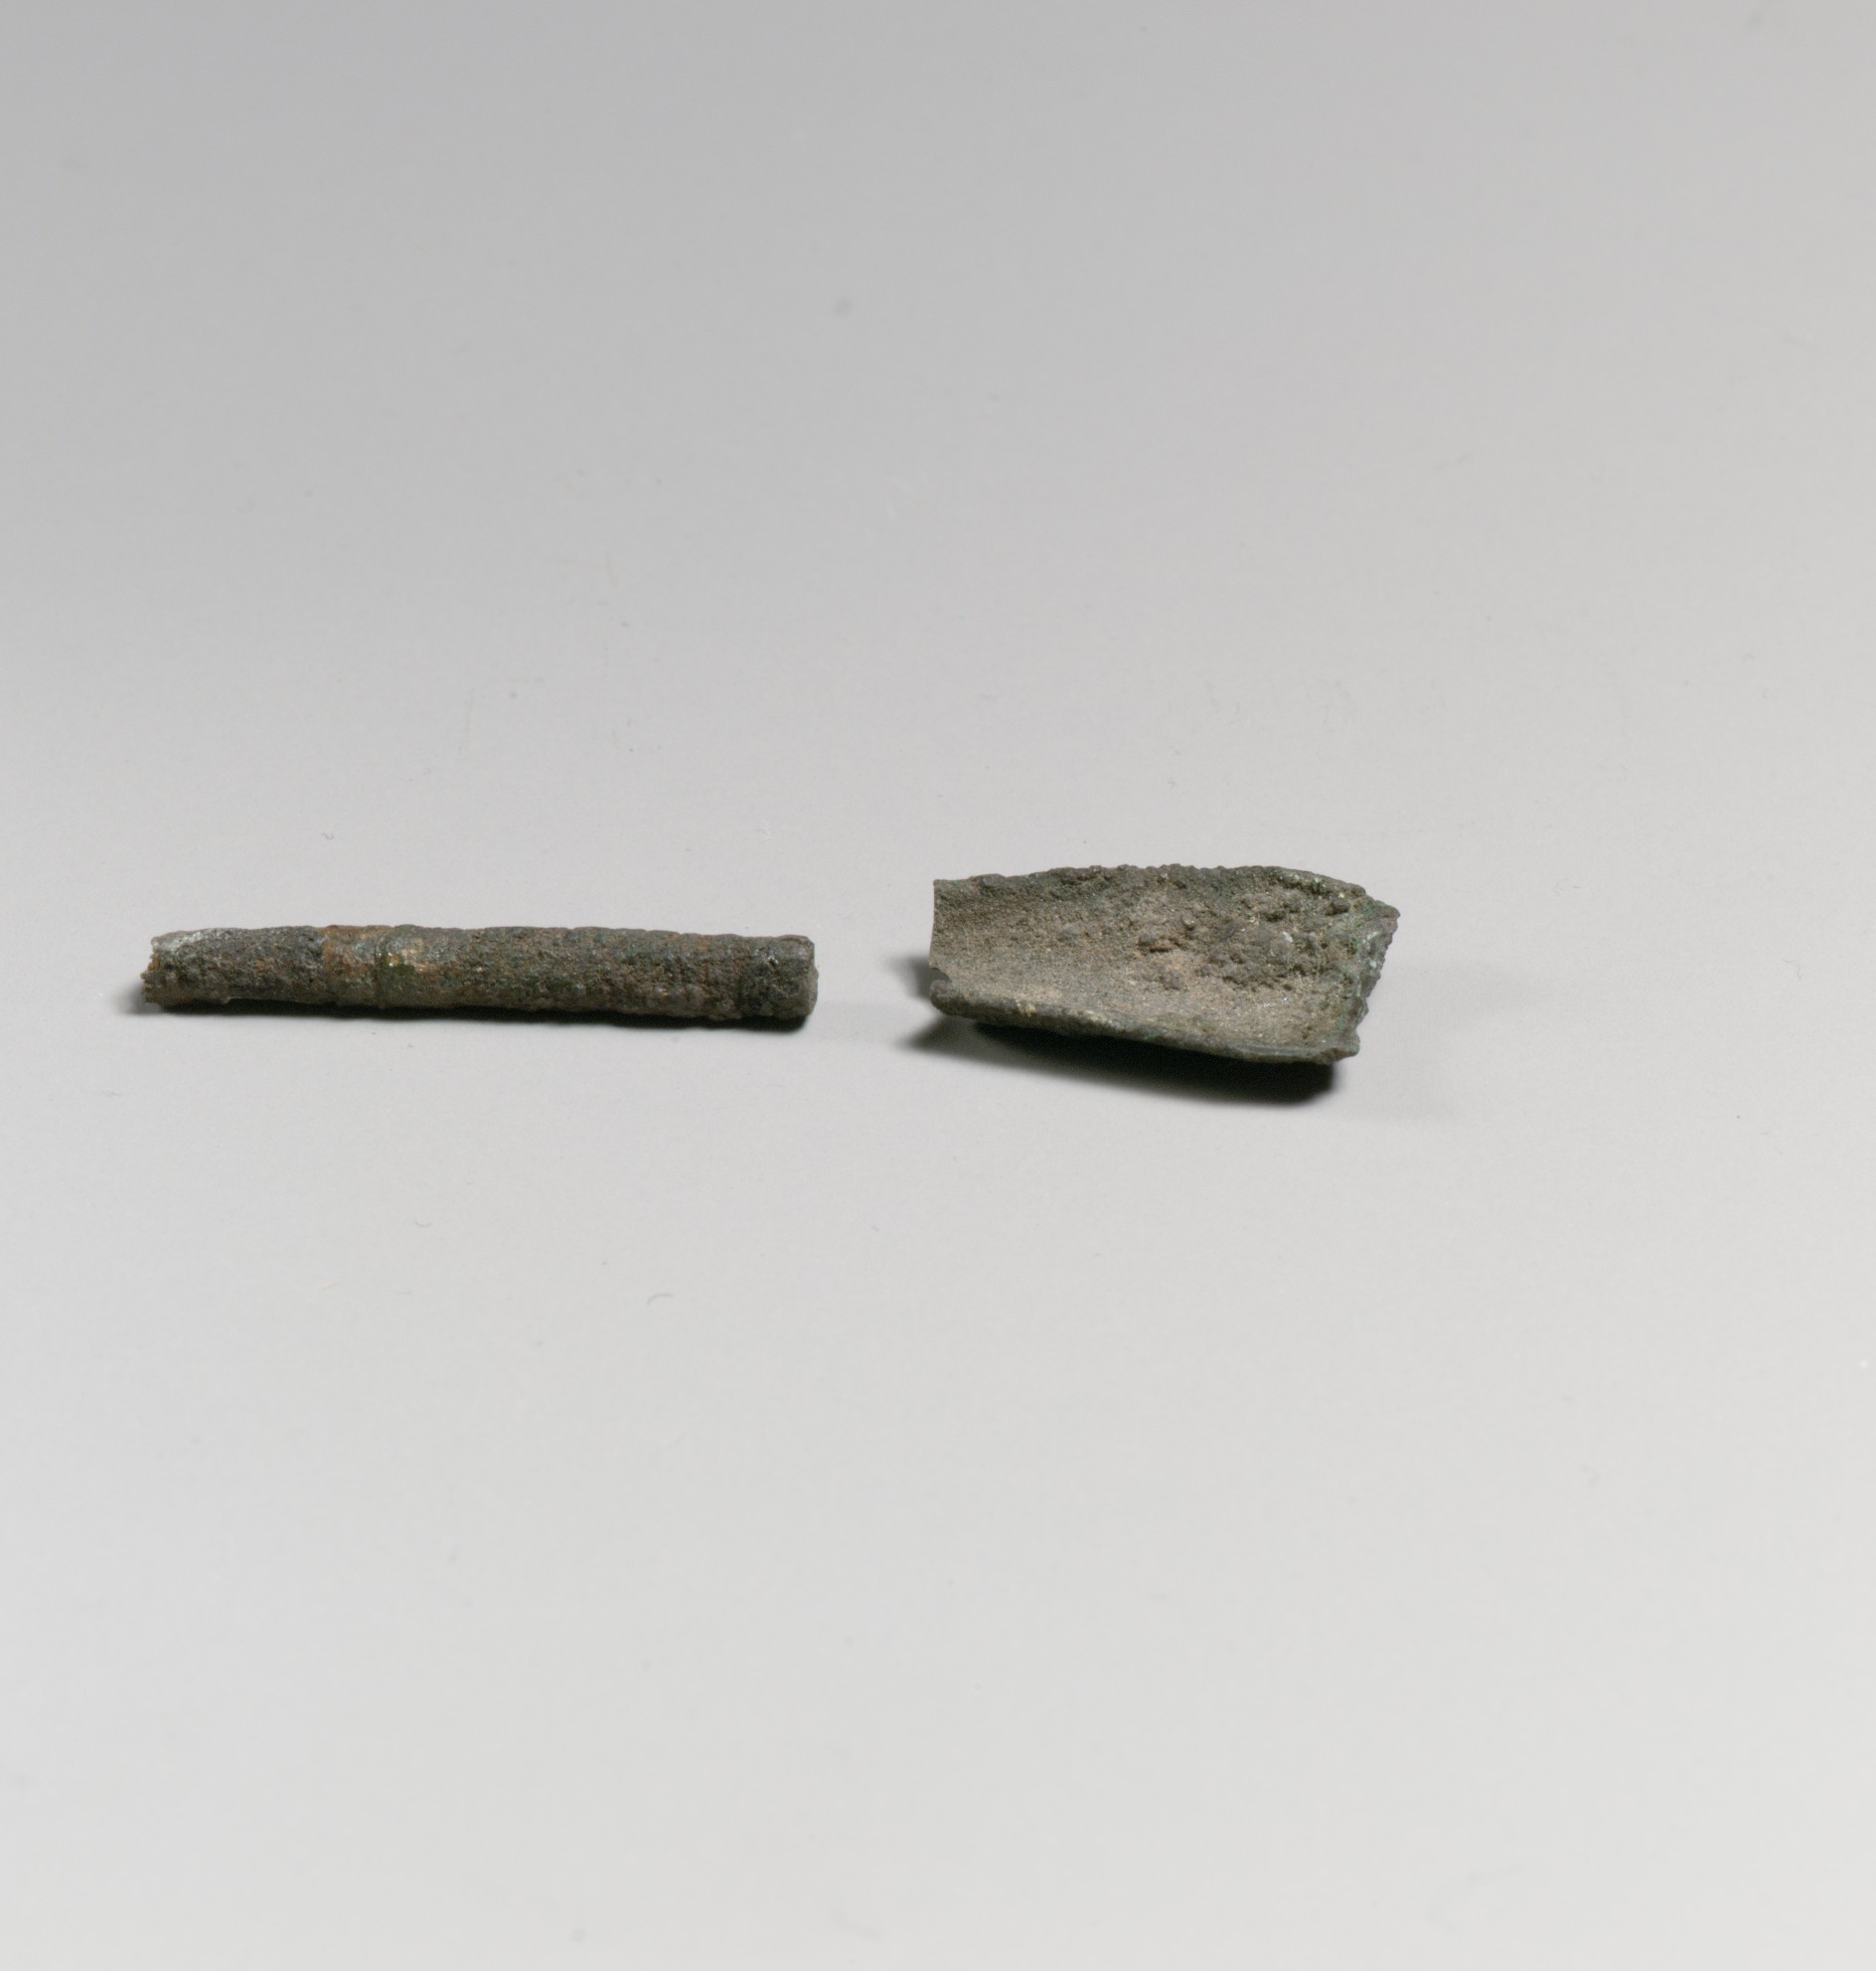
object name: spoon probe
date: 7000 BCE-330 CE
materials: bronze